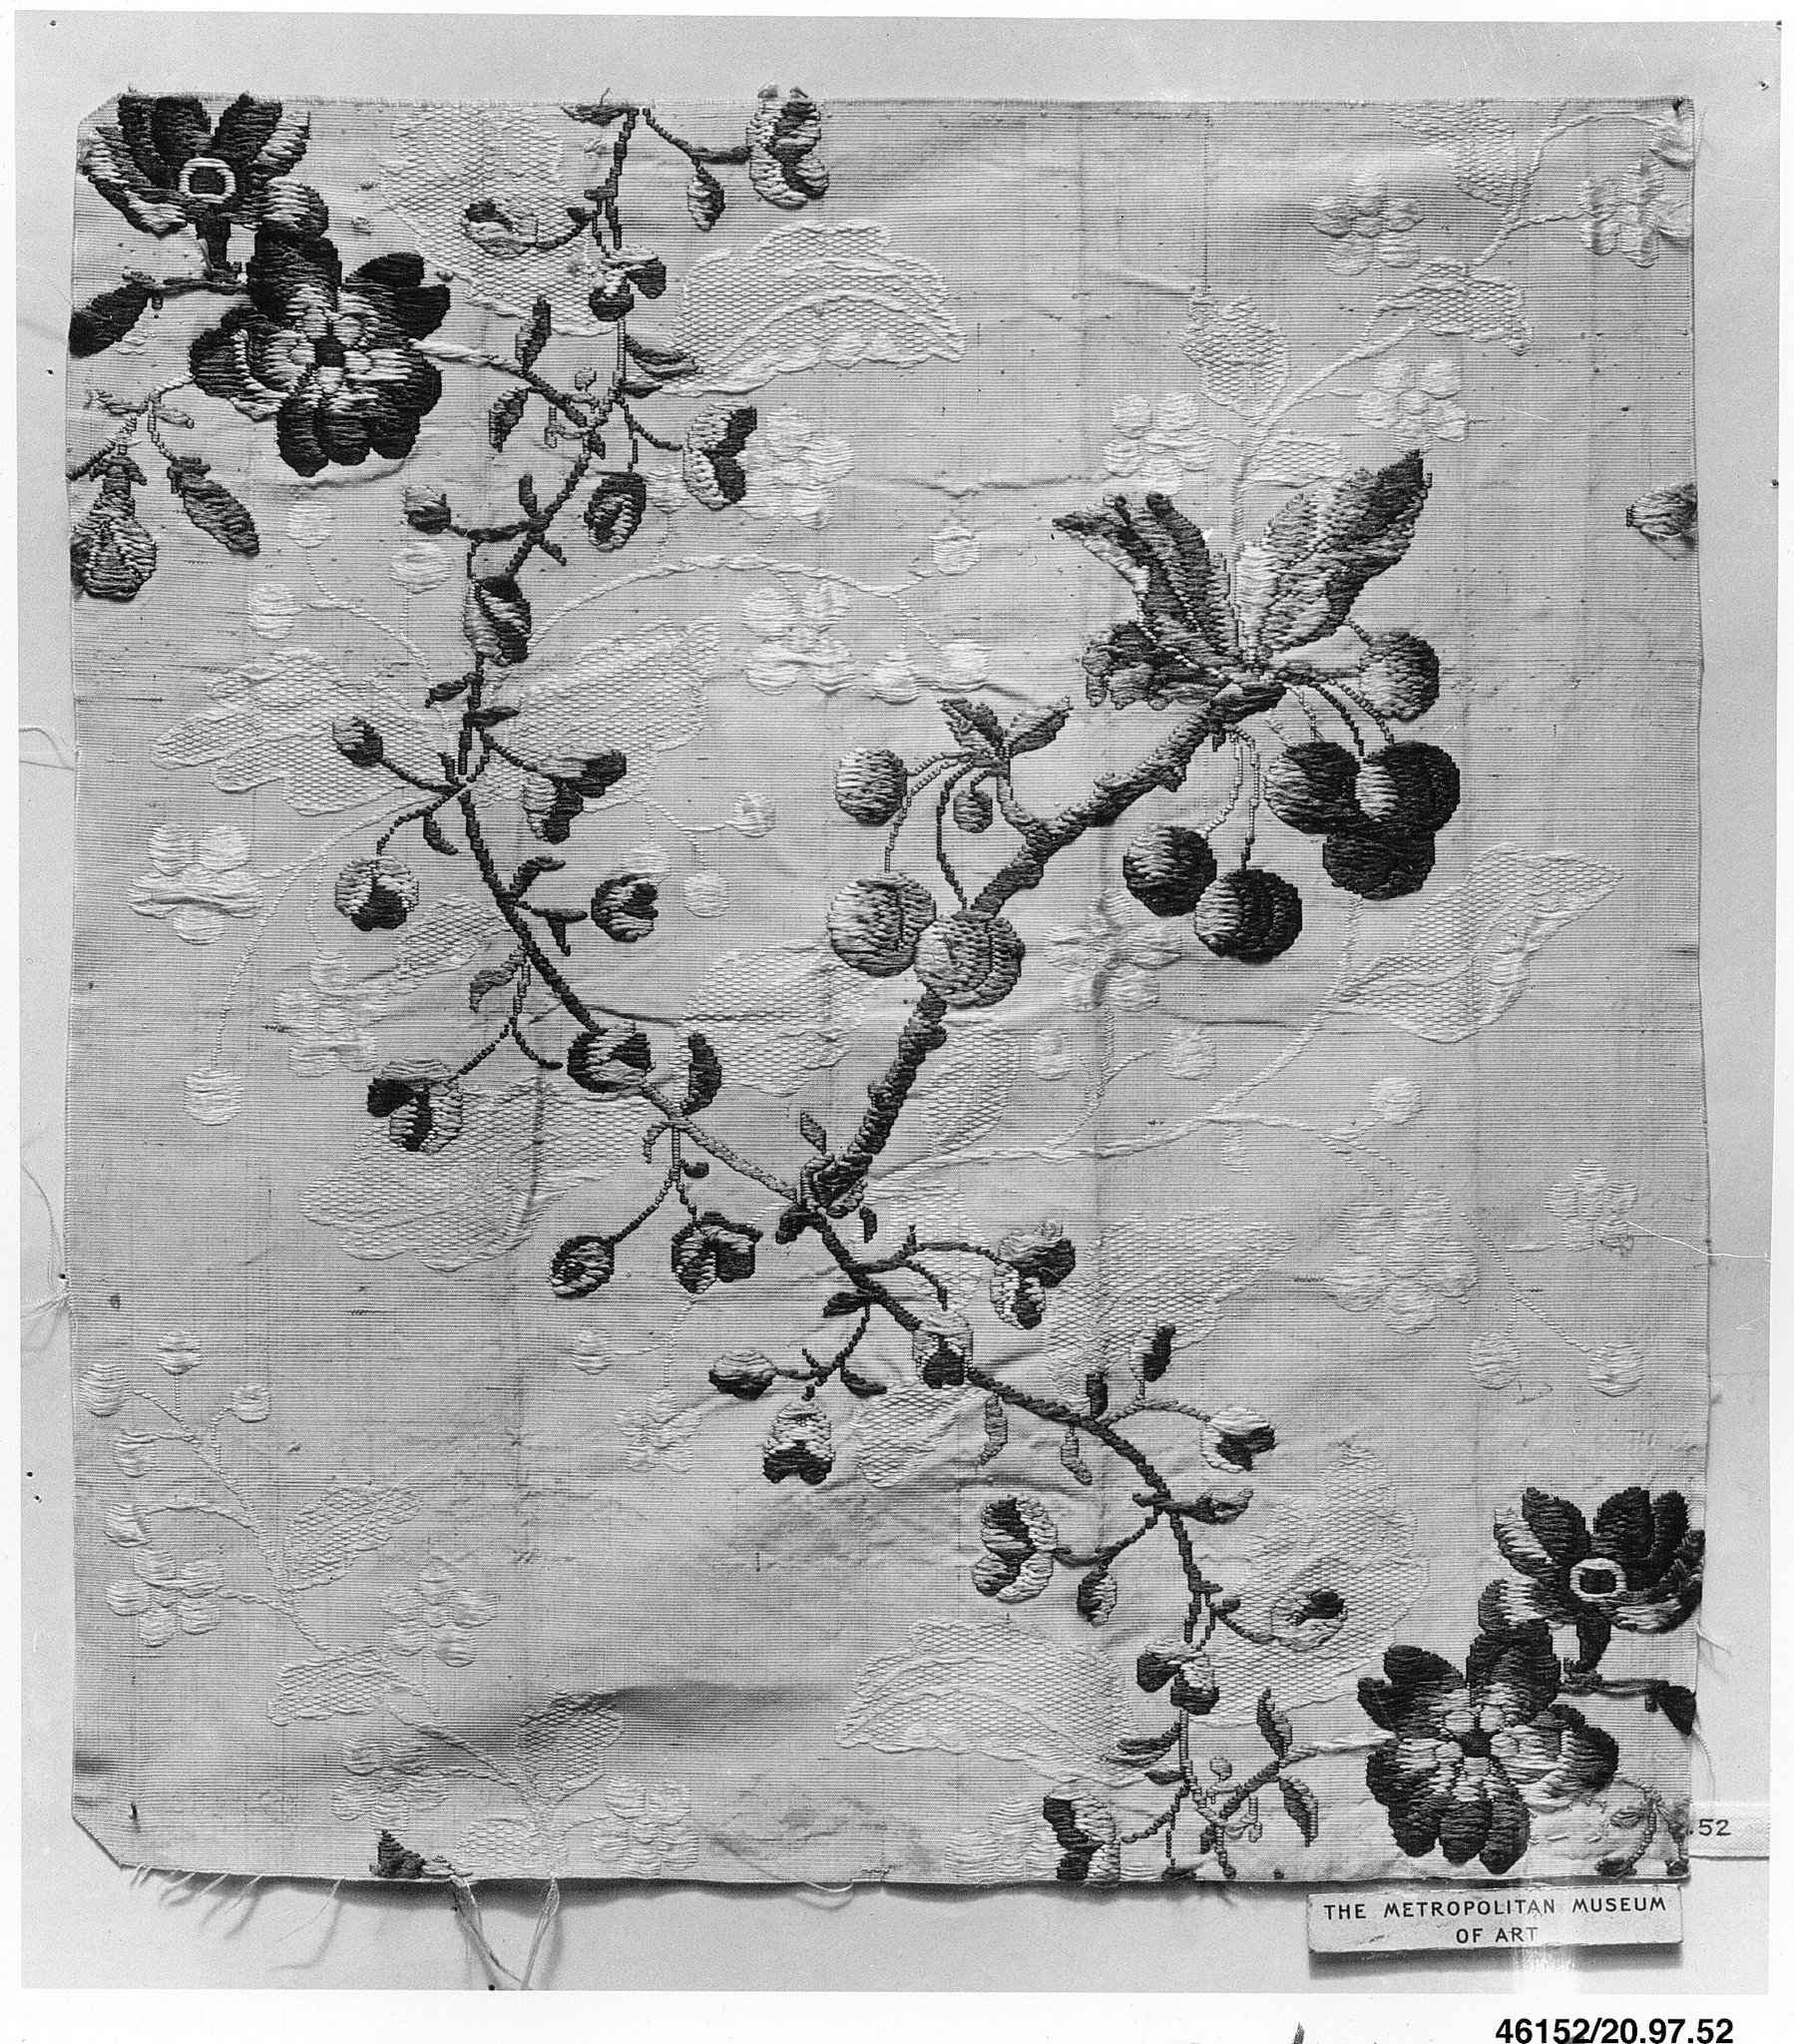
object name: piece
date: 1750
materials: silk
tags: flowers,leaves